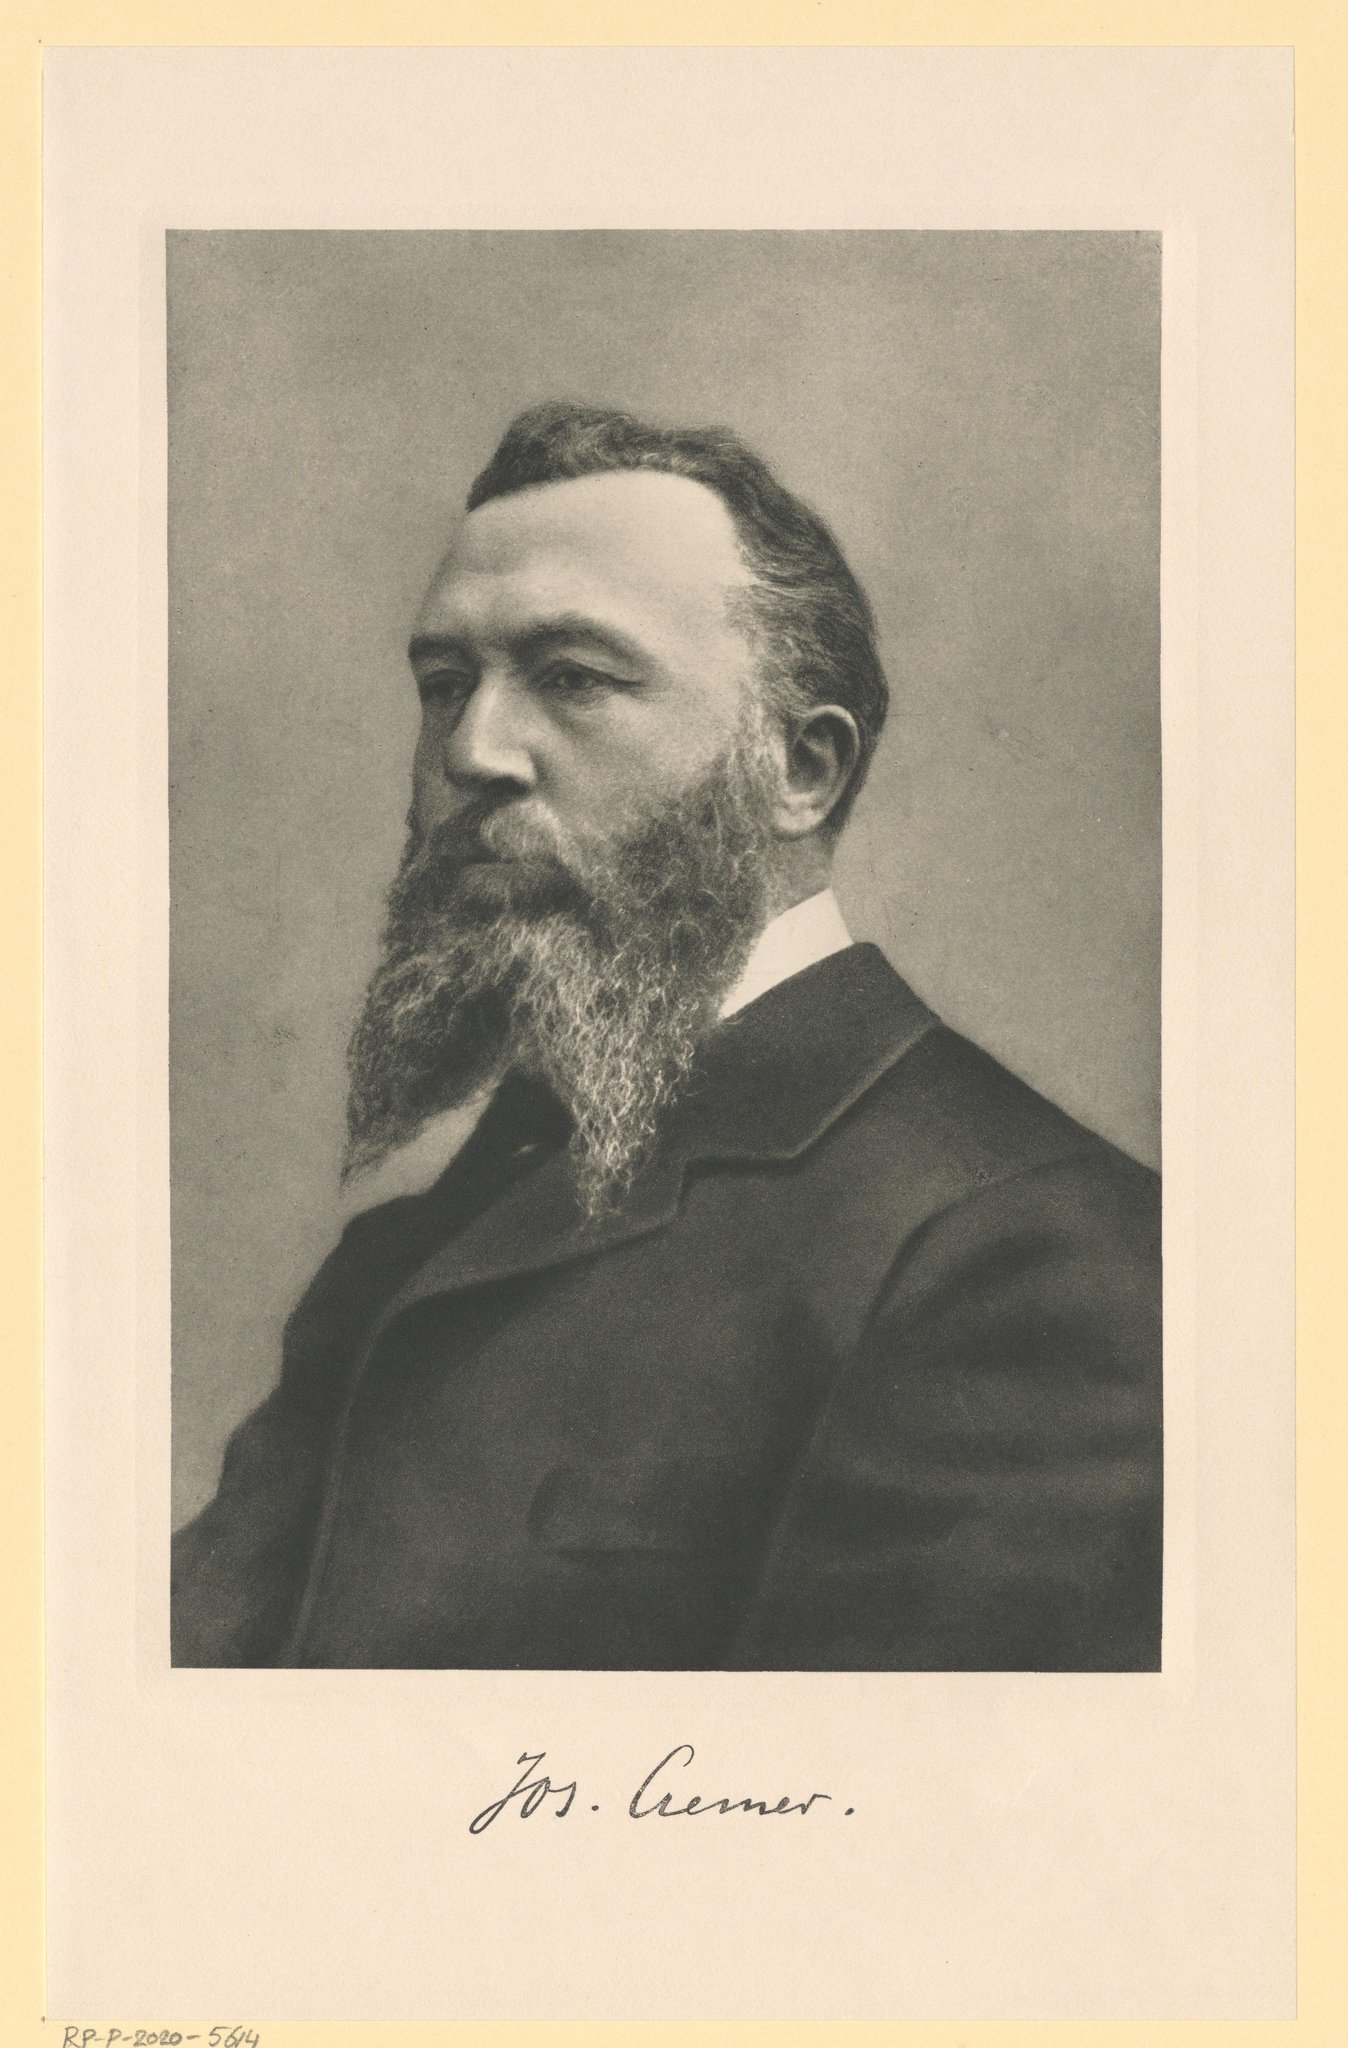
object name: photomechanical print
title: Portret van Josef Cremer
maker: Anonymous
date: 1894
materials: paper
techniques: rotogravure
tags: historical persons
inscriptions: date